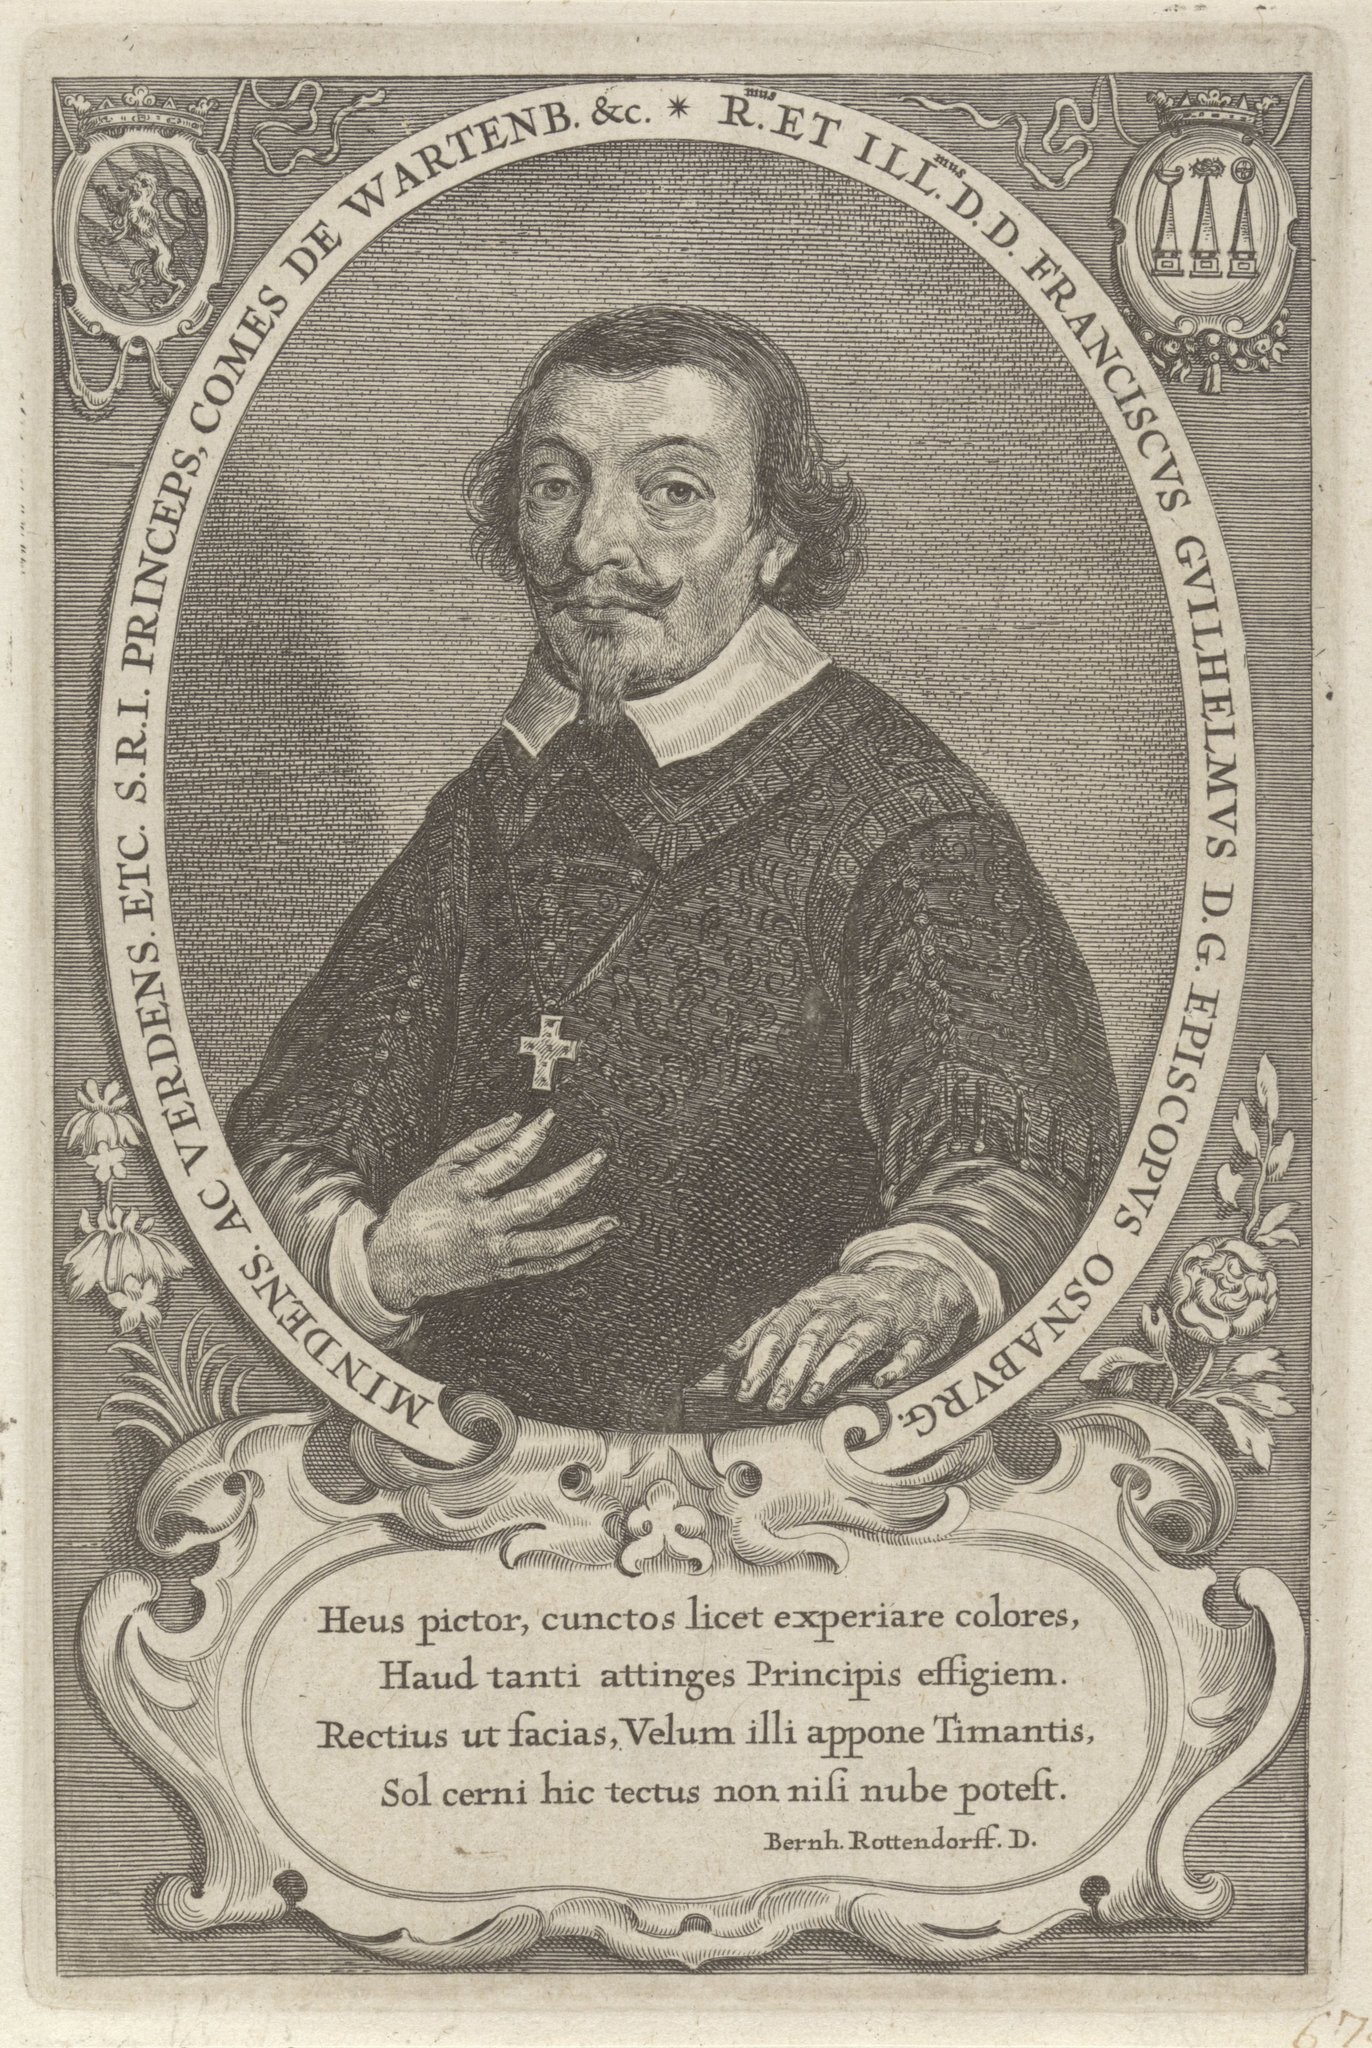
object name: print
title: Portret van Franz Wilhelm von Wartenberg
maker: bernhard rottendorff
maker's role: arts, bibliofiel, raadsheer, schrijver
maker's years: 1594-1670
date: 1625-1637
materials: paper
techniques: engraving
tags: priest, archbishop, bishop, etc. (roman catholic)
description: Prent waarschijnlijk uit: Ferrari, Giovanni Battista. Flora, seu De florum cultura. Amsterdam: Johannes Janssonius, 1664. De prent wordt in de literatuur zowel aan Jonas Suyderhoef als aan Lucas Kilian toegeschreven.